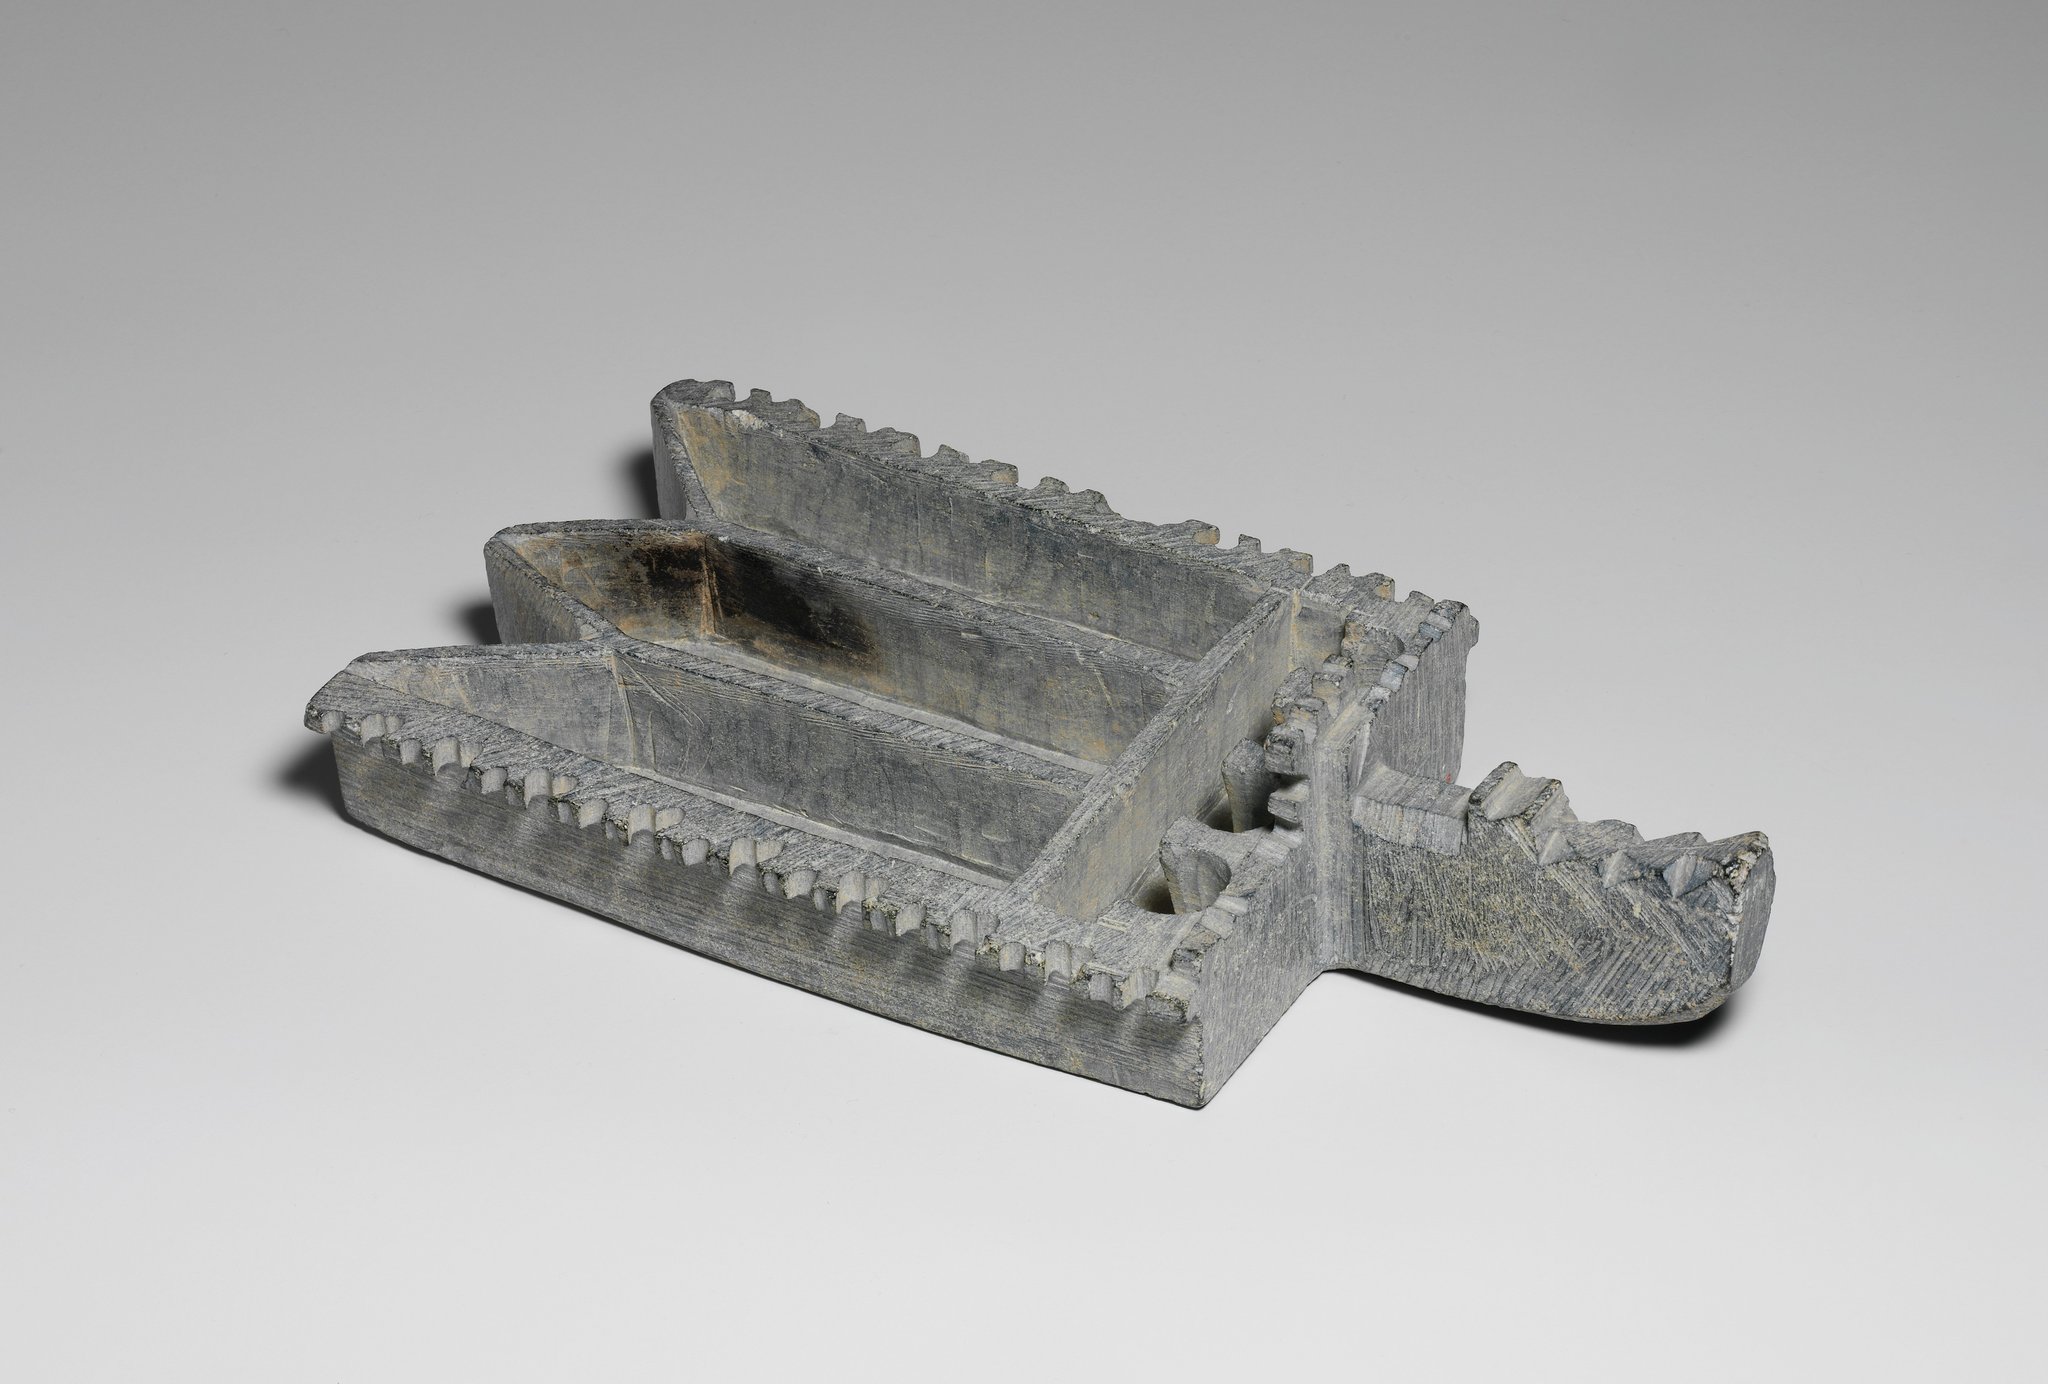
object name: lamp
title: Stone Oil Lamp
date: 801-900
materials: stone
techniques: carving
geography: iran